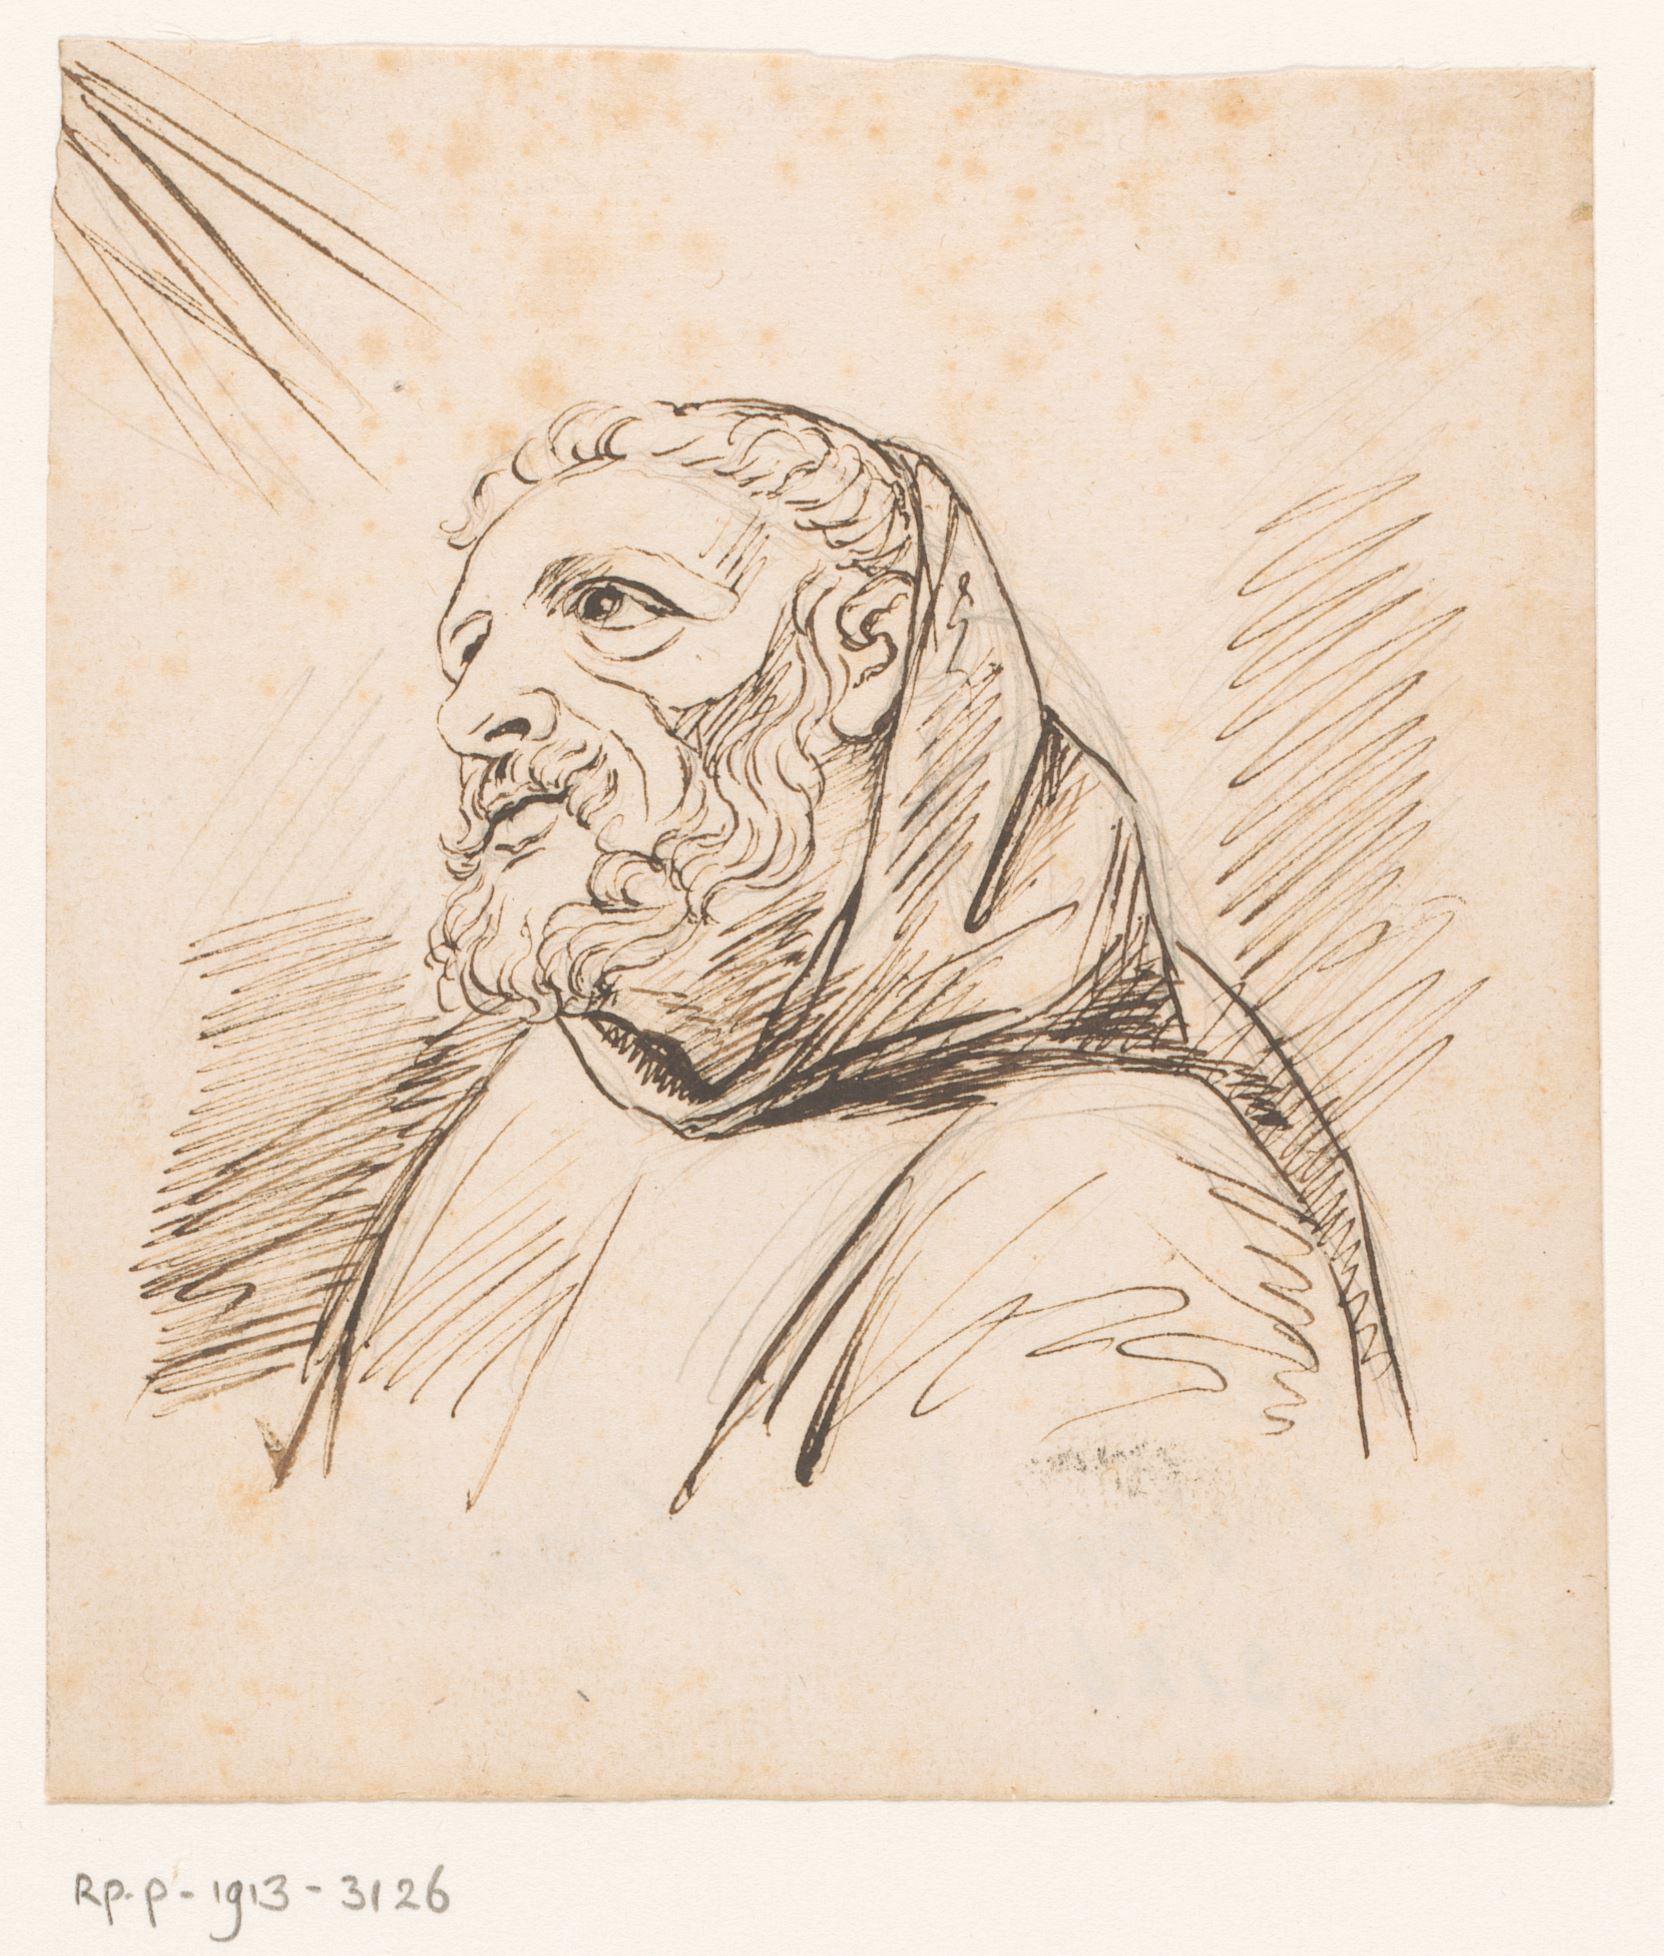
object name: drawing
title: Buste van een monnik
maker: van der straalen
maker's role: print maker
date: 1775-1874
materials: ink, paper, pencil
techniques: brush, pen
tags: monk(s), friar(s)